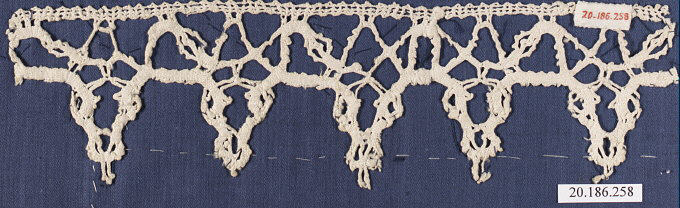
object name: edging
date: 1501-1700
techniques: lace